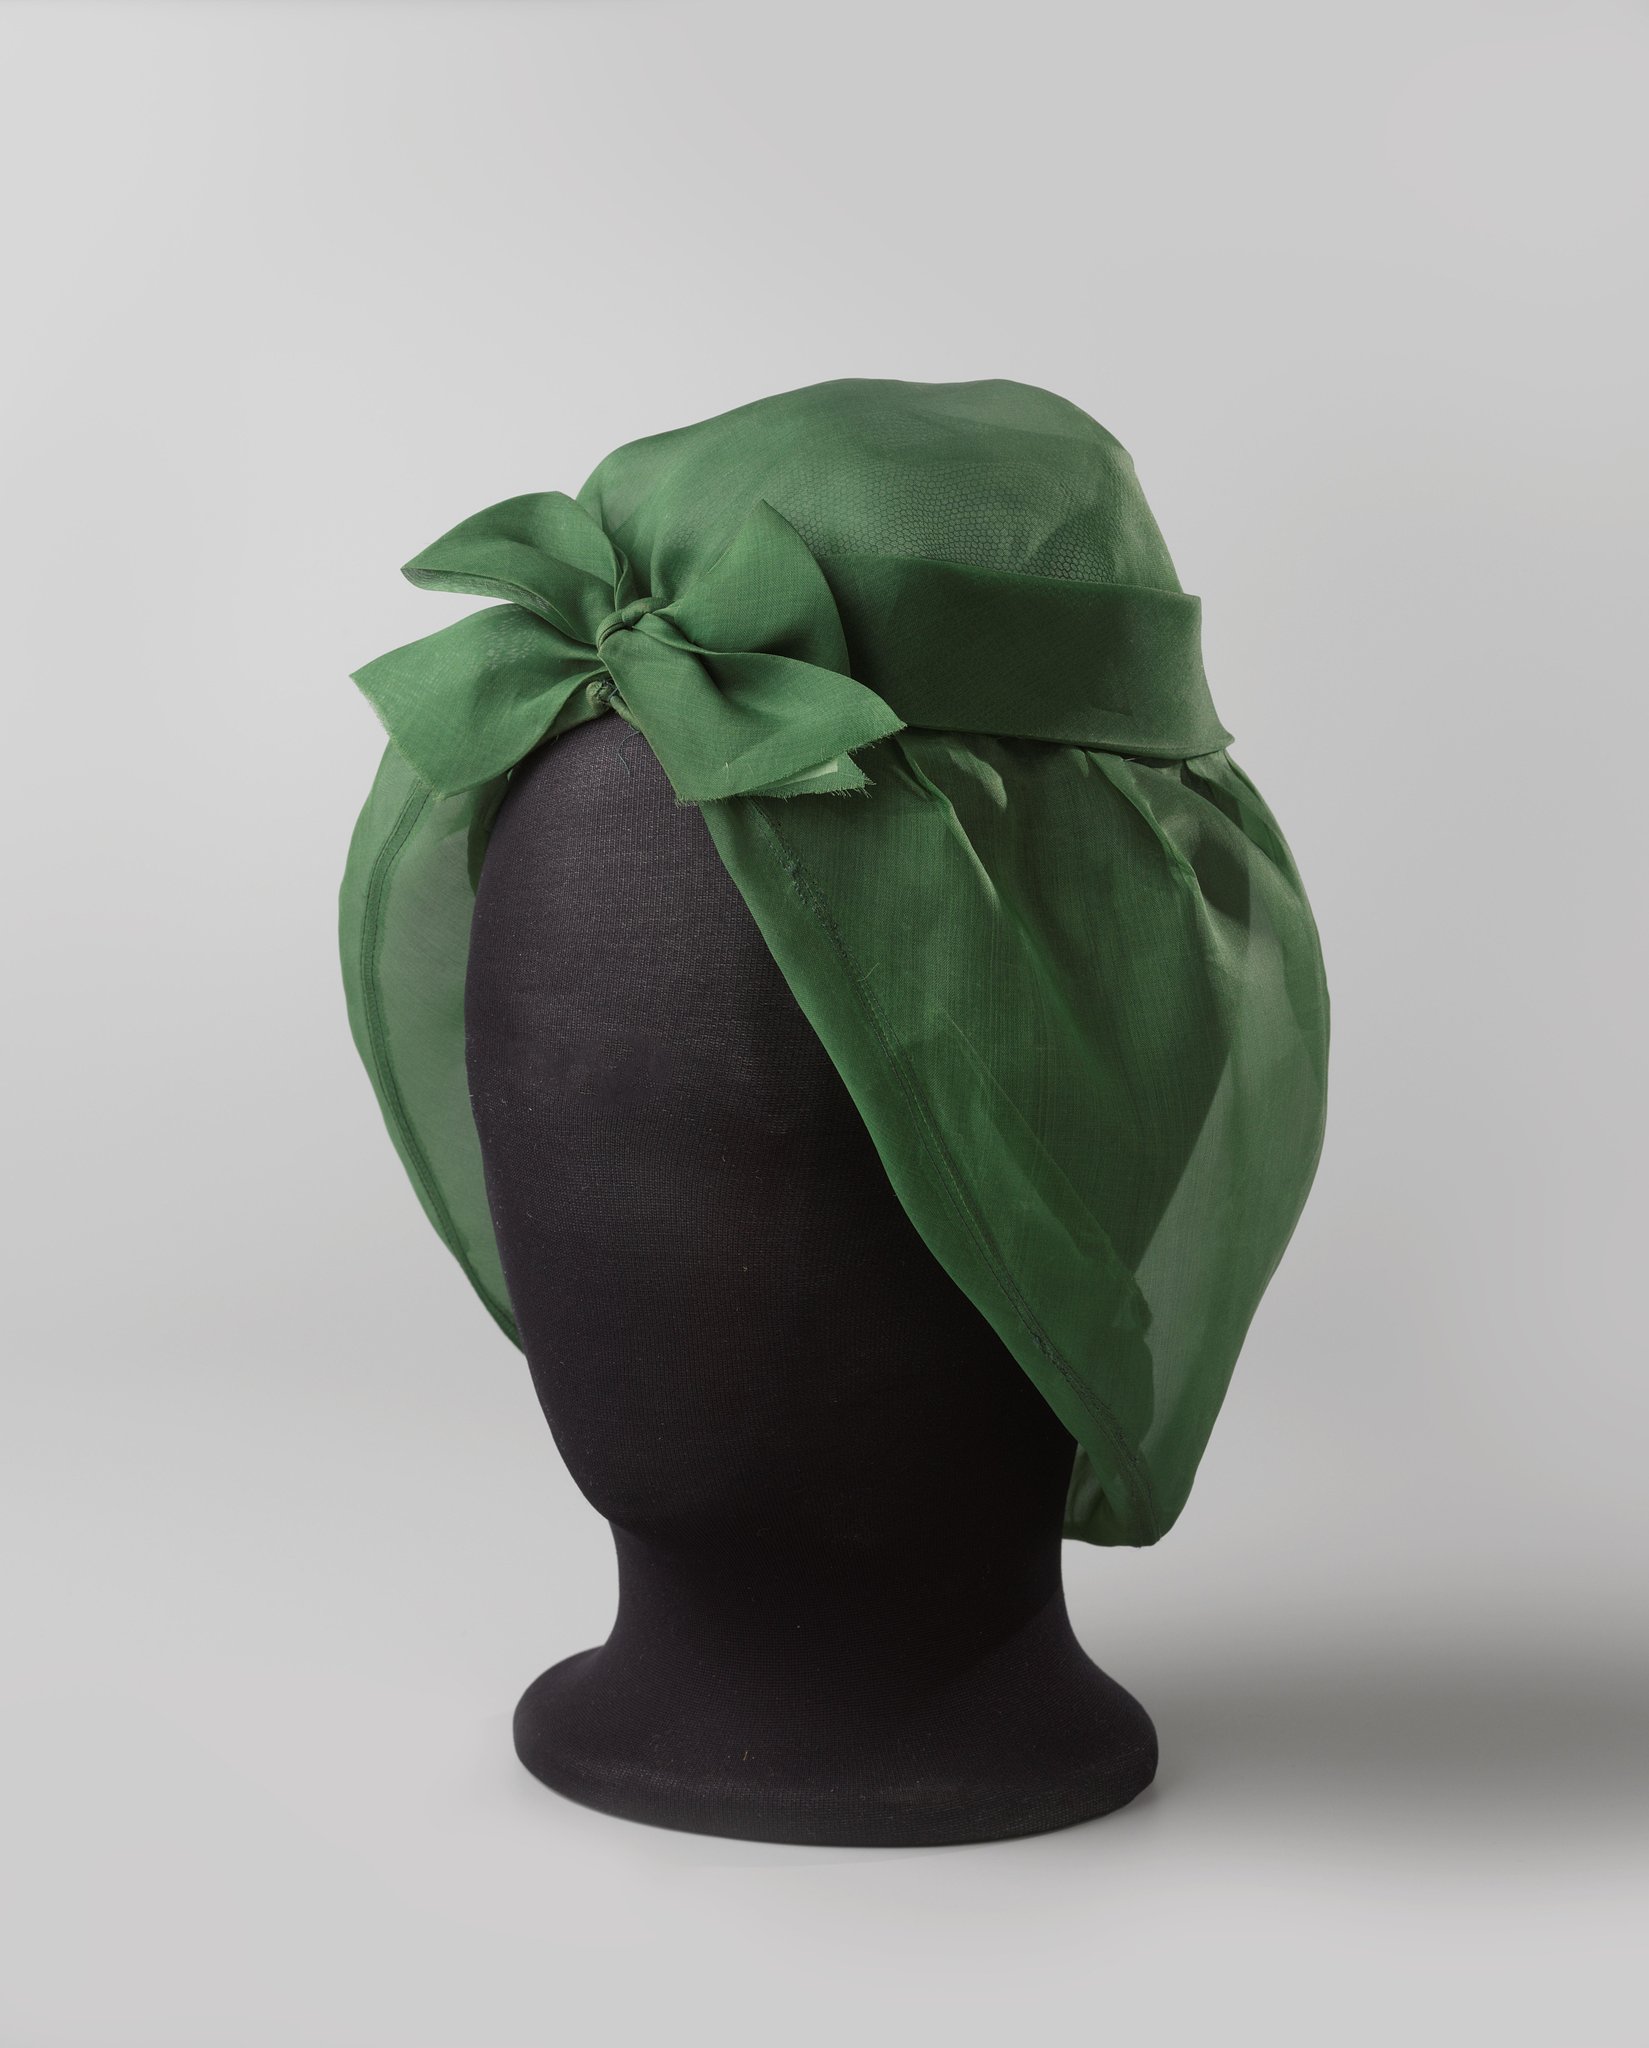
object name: hat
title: Hoed van groene organza met kleine bol aan de achterzijde waaromheen een lint met strik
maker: paulette modes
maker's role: hoedenmaakster, modiste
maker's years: 1900-1984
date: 1952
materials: textile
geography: paris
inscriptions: mark: ‘PAULETTE’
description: Hoed van groene organza met kleine bol aan de achterzijde waaromheen een lint met strik.